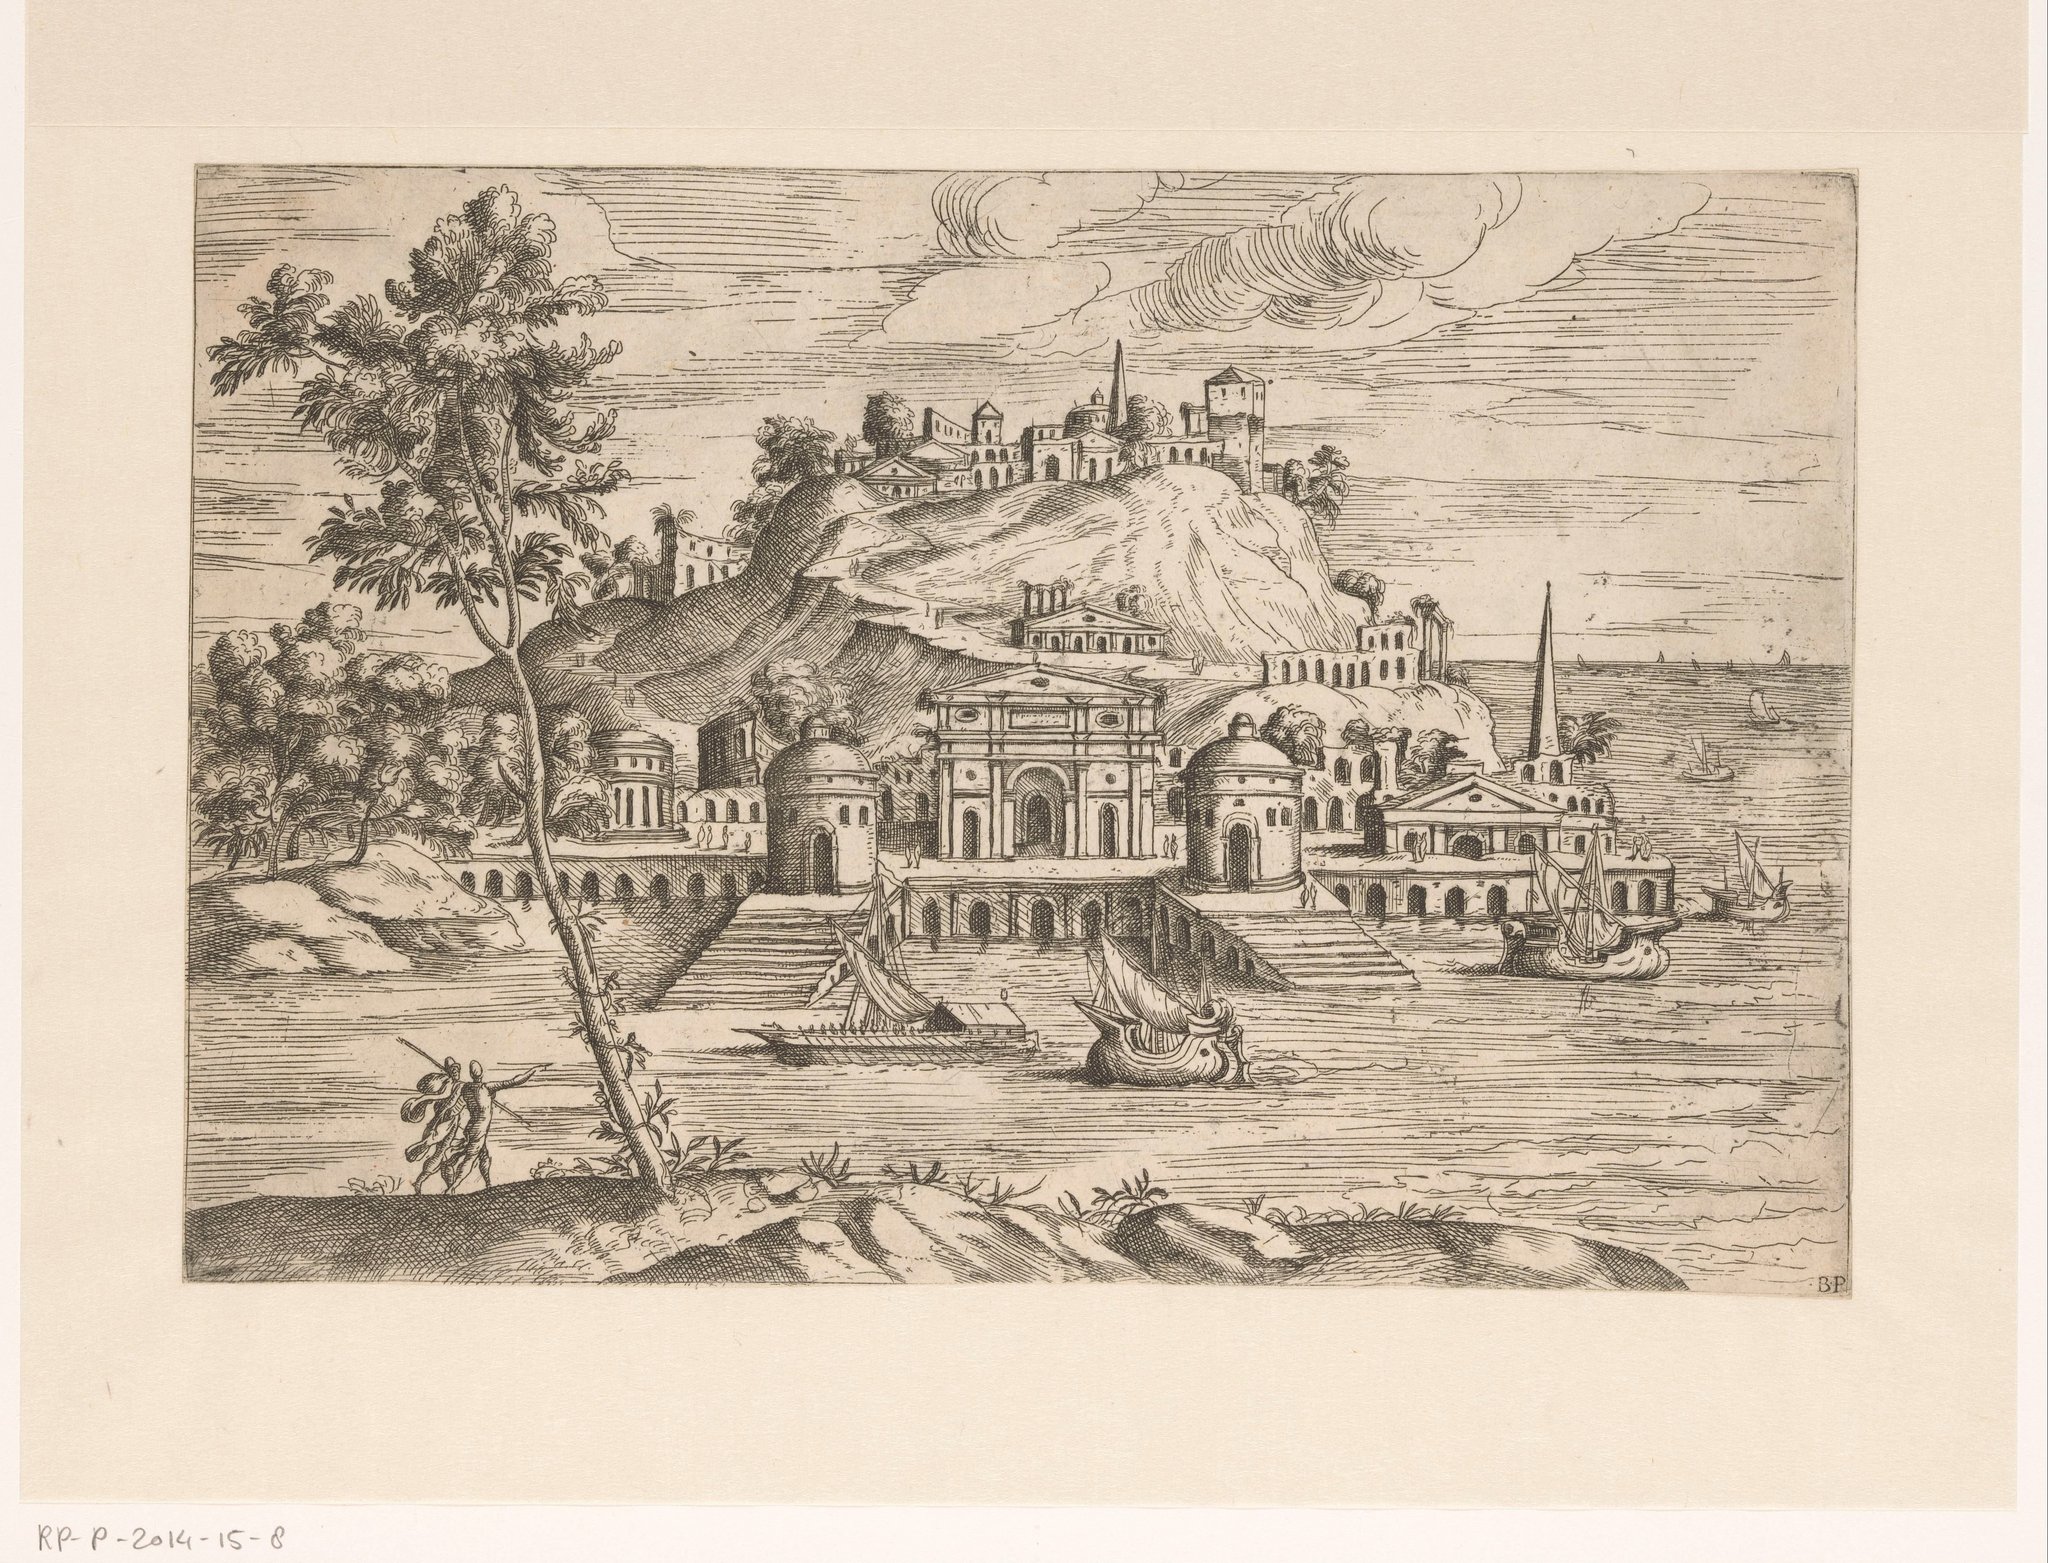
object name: print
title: Landschappen met ruïnes en fantasie-architectuur en figuren in antieke en exotische dracht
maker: giovanni battista pittoni (i)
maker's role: print maker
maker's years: 1520-1583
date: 1560-1570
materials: paper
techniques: etching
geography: vicenza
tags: landscape with ruins, fantastic architecture, unrealistic architectural fantasies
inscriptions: collector's mark: Lugt 2228, collector's mark: Lugt 2760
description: Vermoedelijk is deze prentreeks onbeschreven (vergelijk Passavant, deel 6 p. 169-170, nr. 1). Het is vooralsnog onduidelijk of de reeks compleet is of wellicht uit meer prenten bestond.